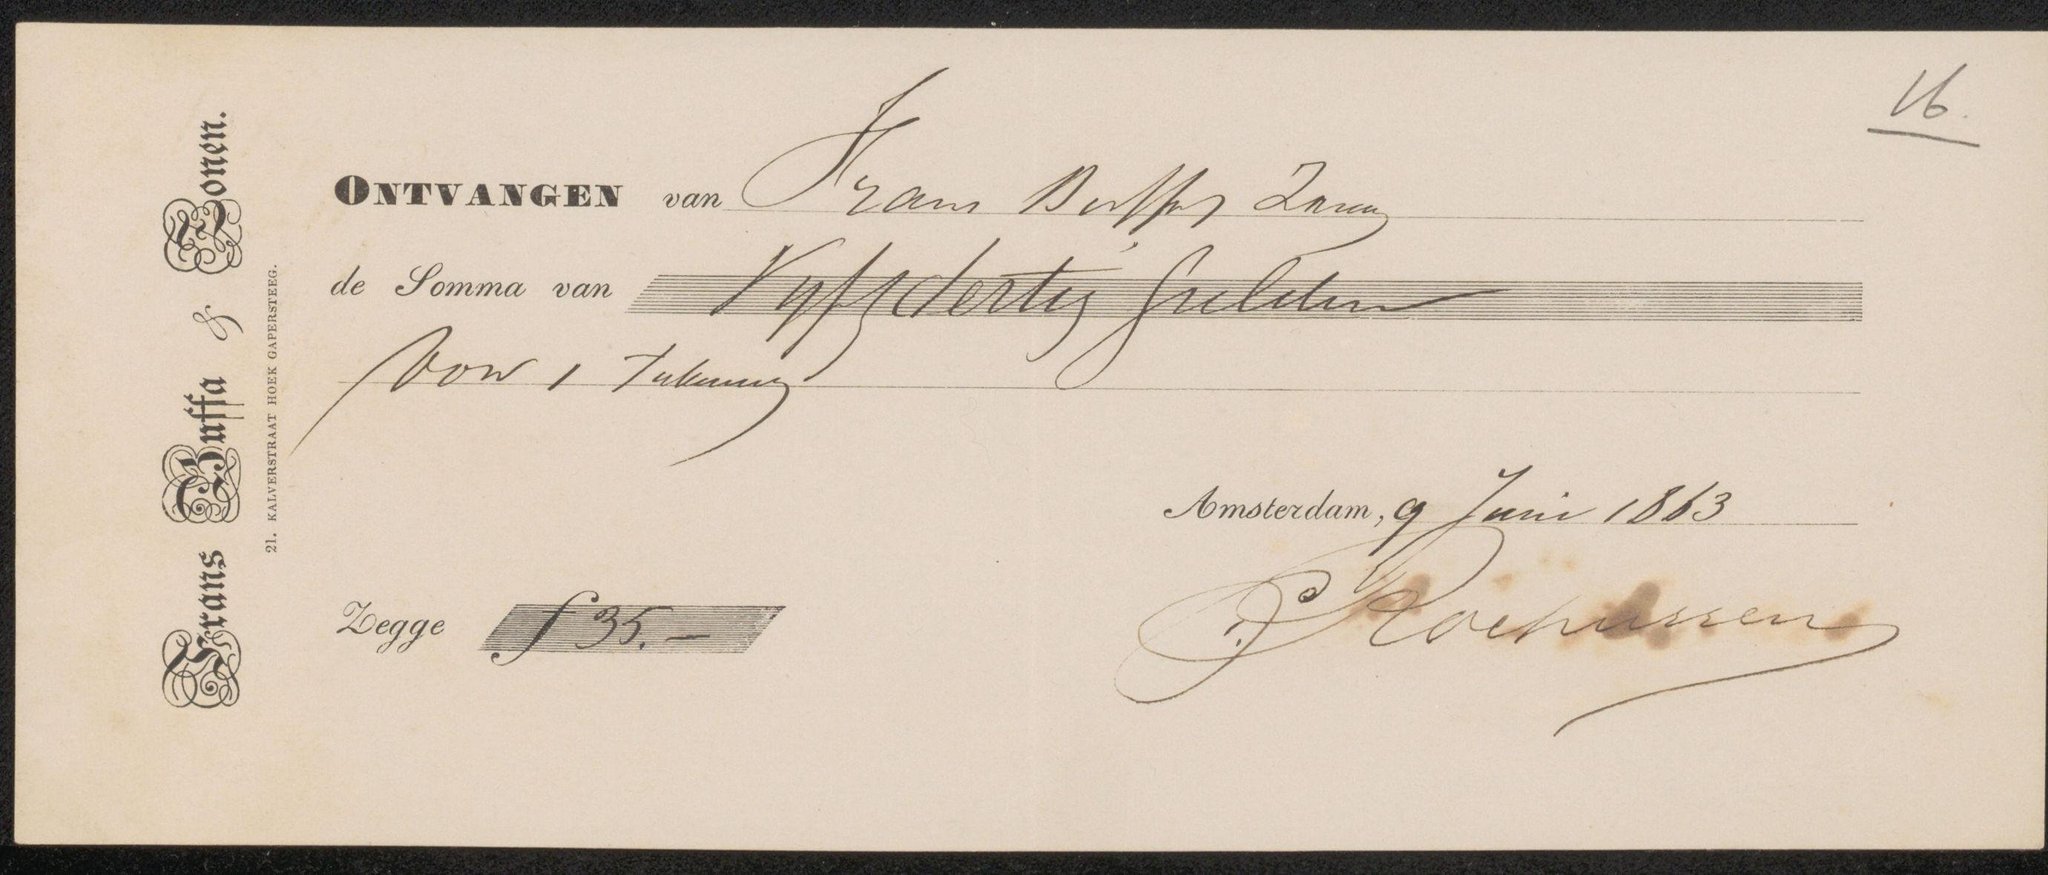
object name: ontvangstbewijs, kwitantie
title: Kwitantie voor Charles Rochussen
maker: charles rochussen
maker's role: draughtsman, painter, print maker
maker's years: 1814-1894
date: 1863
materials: ink, paper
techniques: pen, printing, writing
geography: amsterdam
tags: drawing, money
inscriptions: collector's mark: Lugt 2233